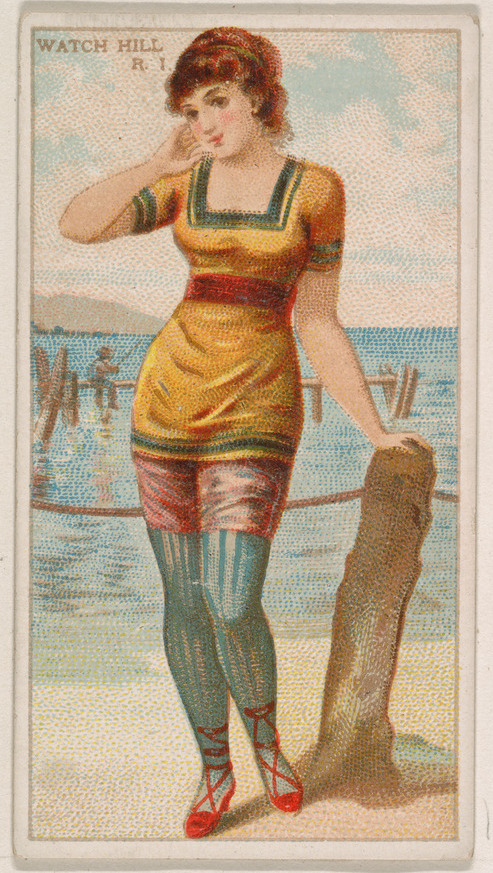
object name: print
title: Watch Hill, Rhode Island, from the Surf Beauties series (N232), issued by Kinney Bros.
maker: kinney brothers tobacco company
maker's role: publisher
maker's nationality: american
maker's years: 1869-2011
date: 1889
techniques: color lithograph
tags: women,sports